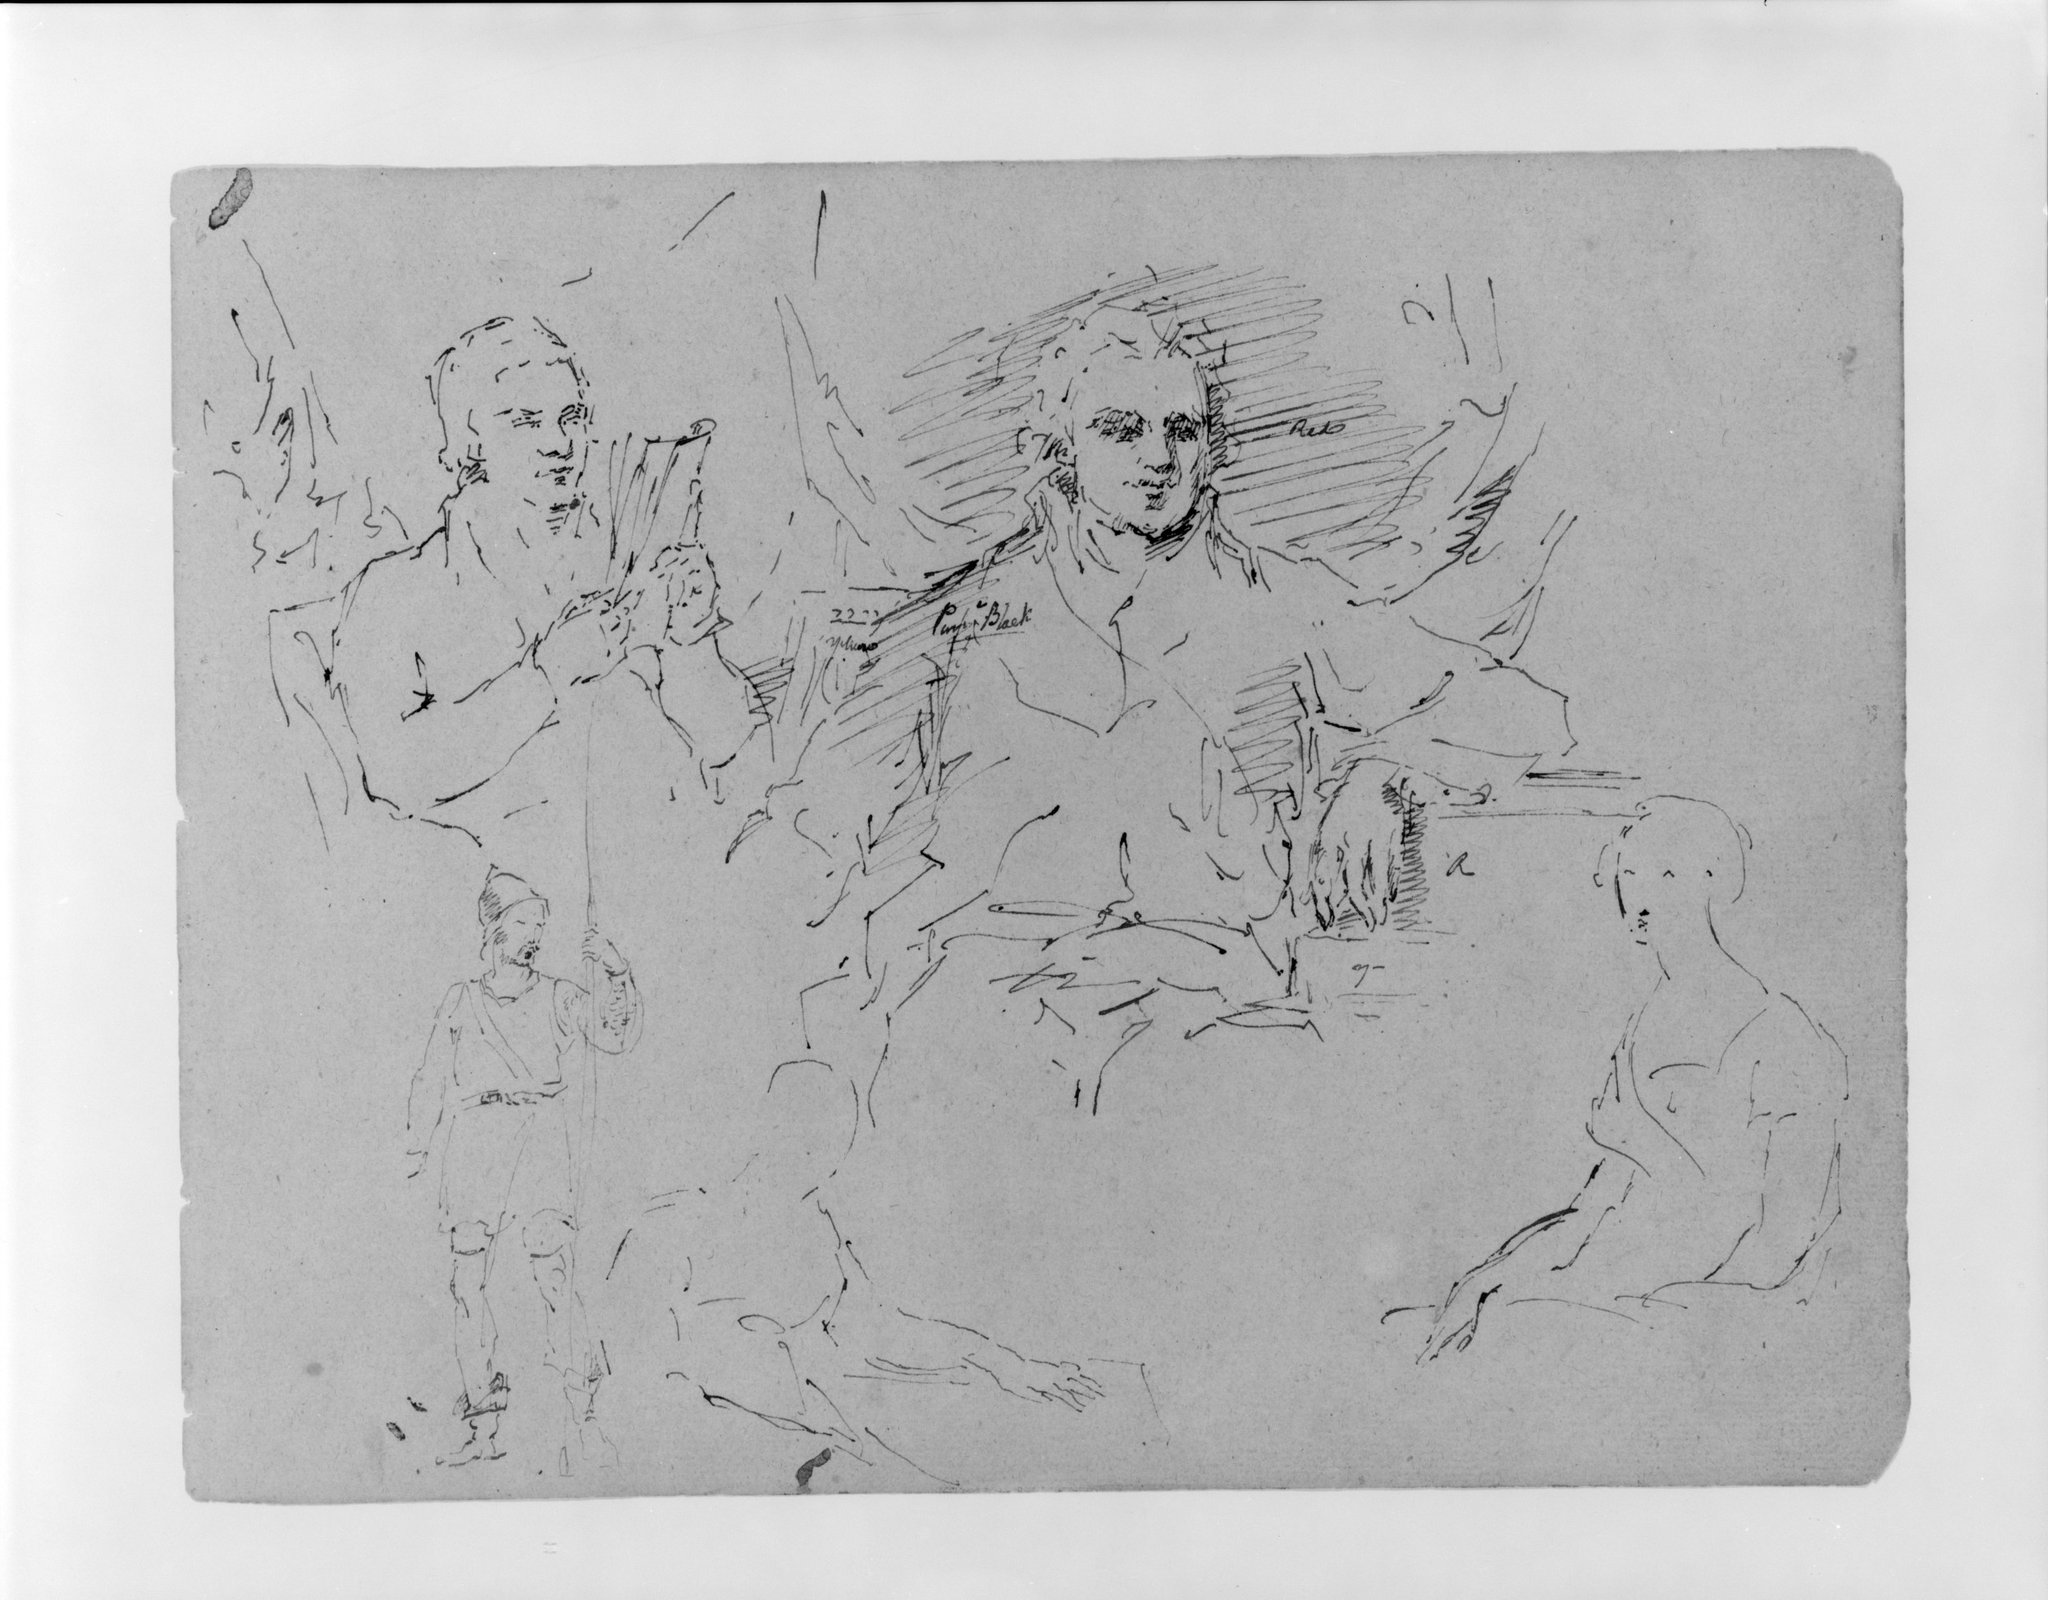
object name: drawing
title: Five Figure Sketches, Including Two Half-length Steated Male Portrait Types (from Sketchbook)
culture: american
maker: thomas sully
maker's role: artist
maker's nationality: american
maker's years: 1783-1872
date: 1810-1820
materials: ink, paper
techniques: wash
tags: men,reading